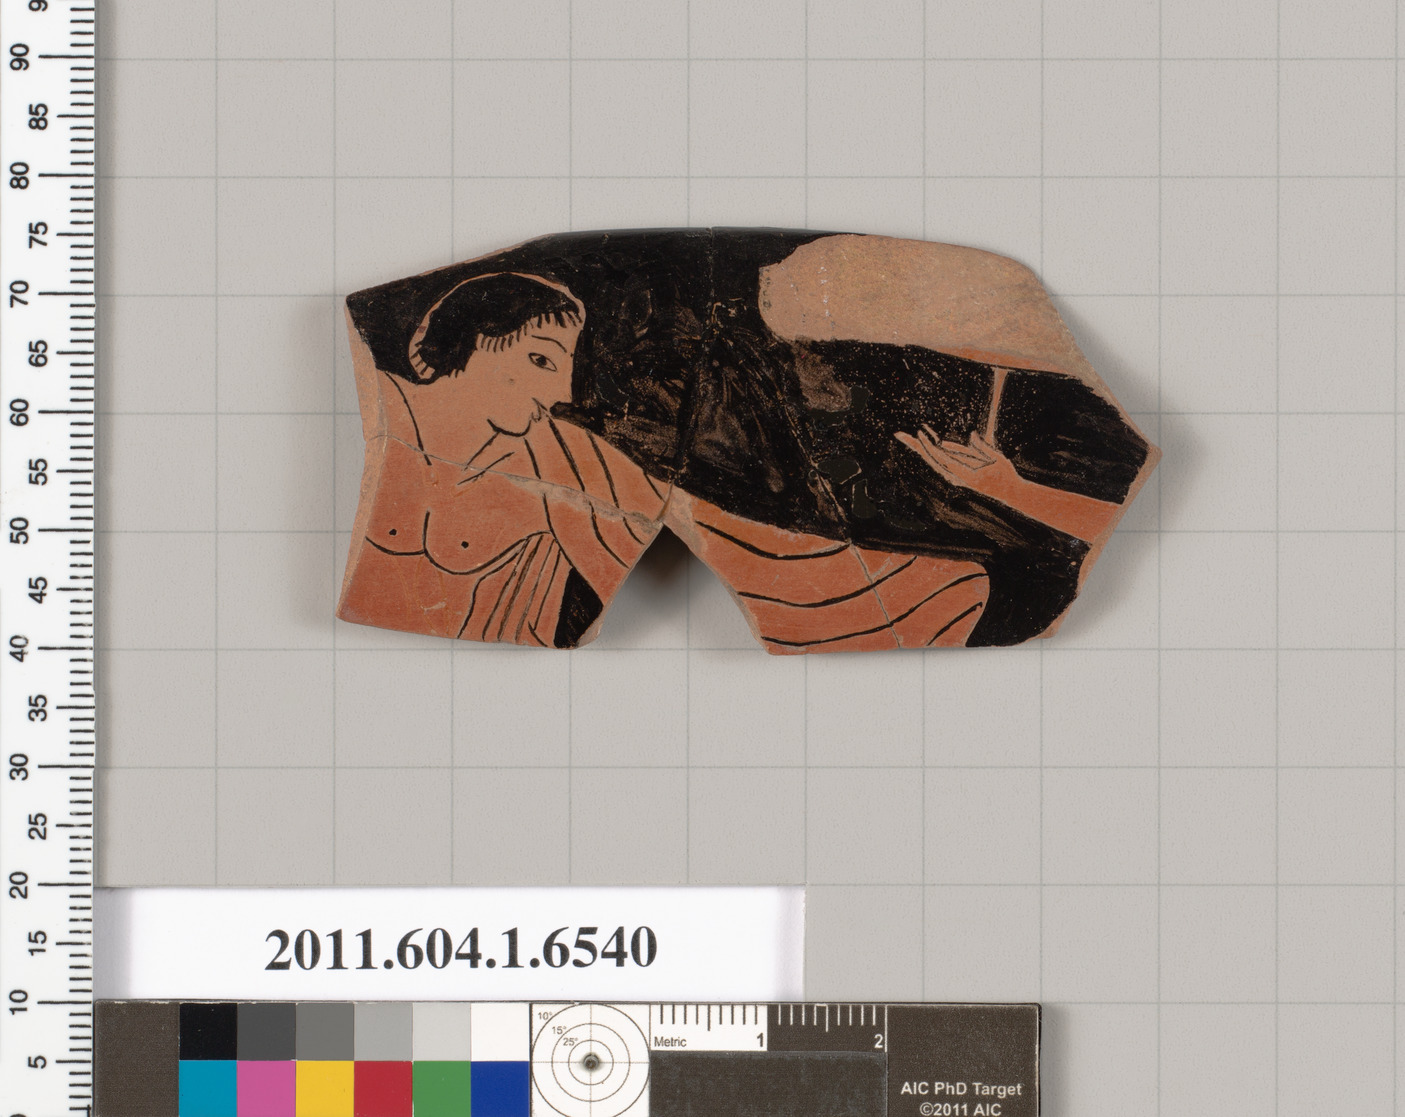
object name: kylix fragment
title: Terracotta rim fragment of a kylix (drinking cup)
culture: greek, attic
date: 490-480 BCE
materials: terracotta